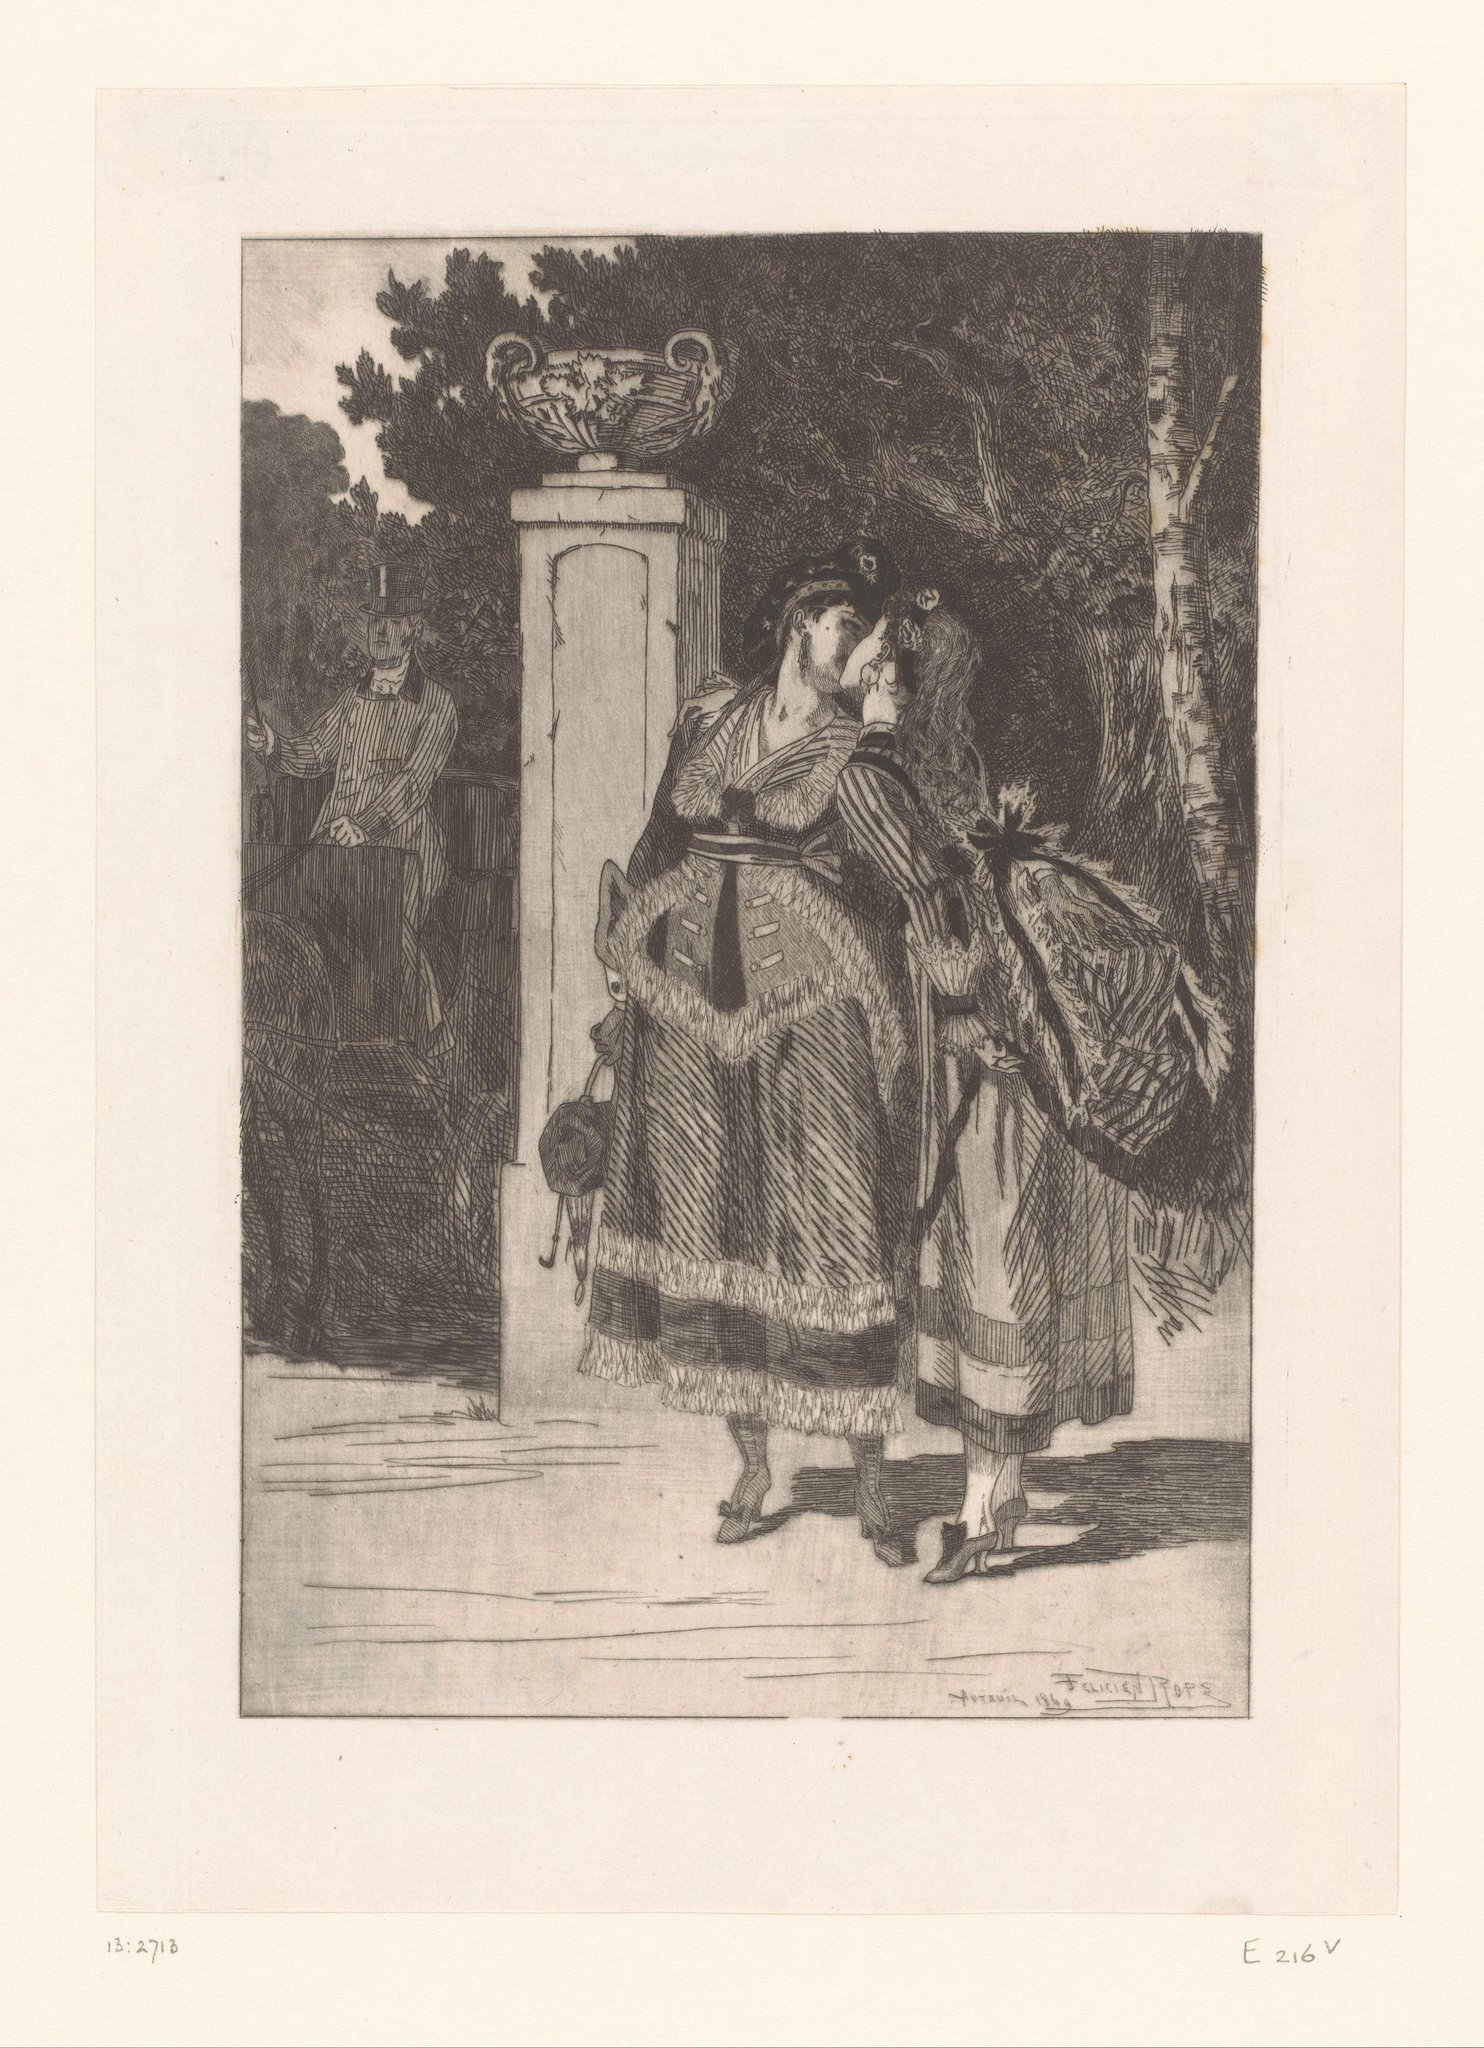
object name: print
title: Afscheid in Auteuil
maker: félicien rops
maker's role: draughtsman, print maker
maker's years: 1833-1898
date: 1869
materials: paper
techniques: aquatint, drypoint, etching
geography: auteuil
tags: homosexual love - cc - homosexual love between women: lesbianism, (lovers) kissing each other, embracing each other, kissing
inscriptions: collector's mark: Lugt 2228, collector's mark: Lugt 1485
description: Twee vrouwen zoenen elkaar terwijl op de achtergrond een koetsier wacht.